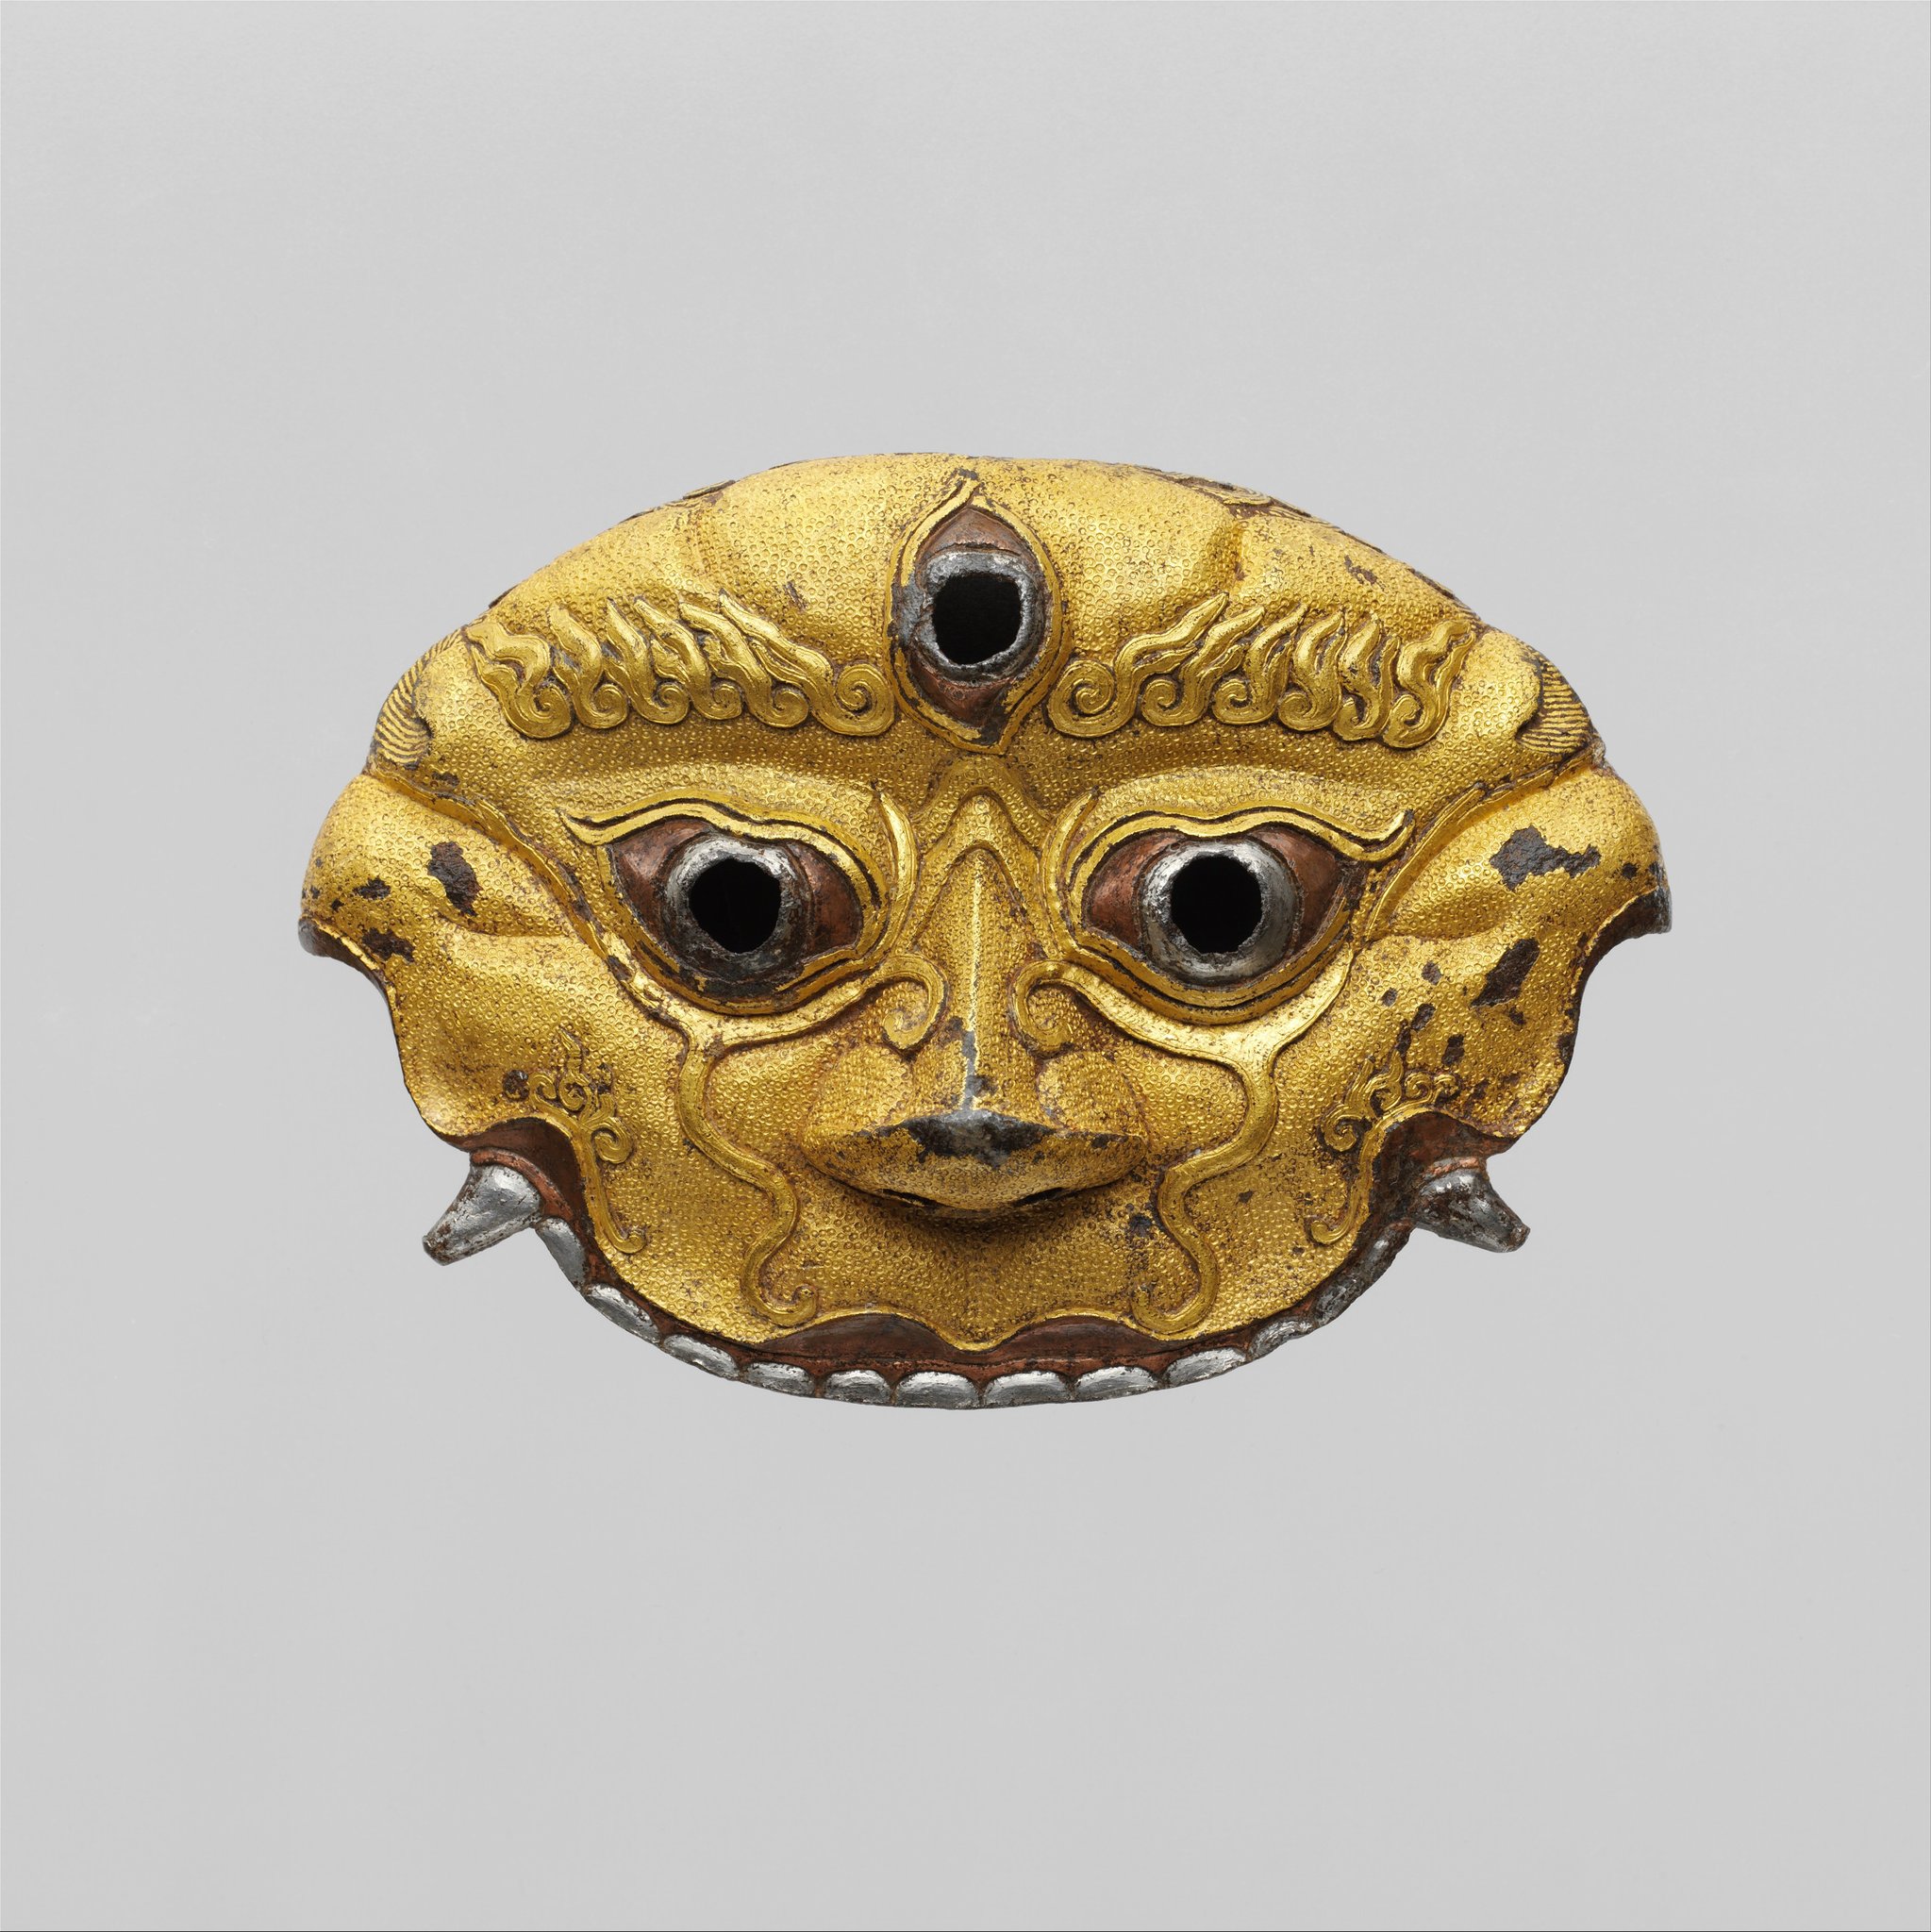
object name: sword guard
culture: tibetan or chinese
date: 1301-1500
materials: copper, gold, iron, silver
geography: tibet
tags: faces